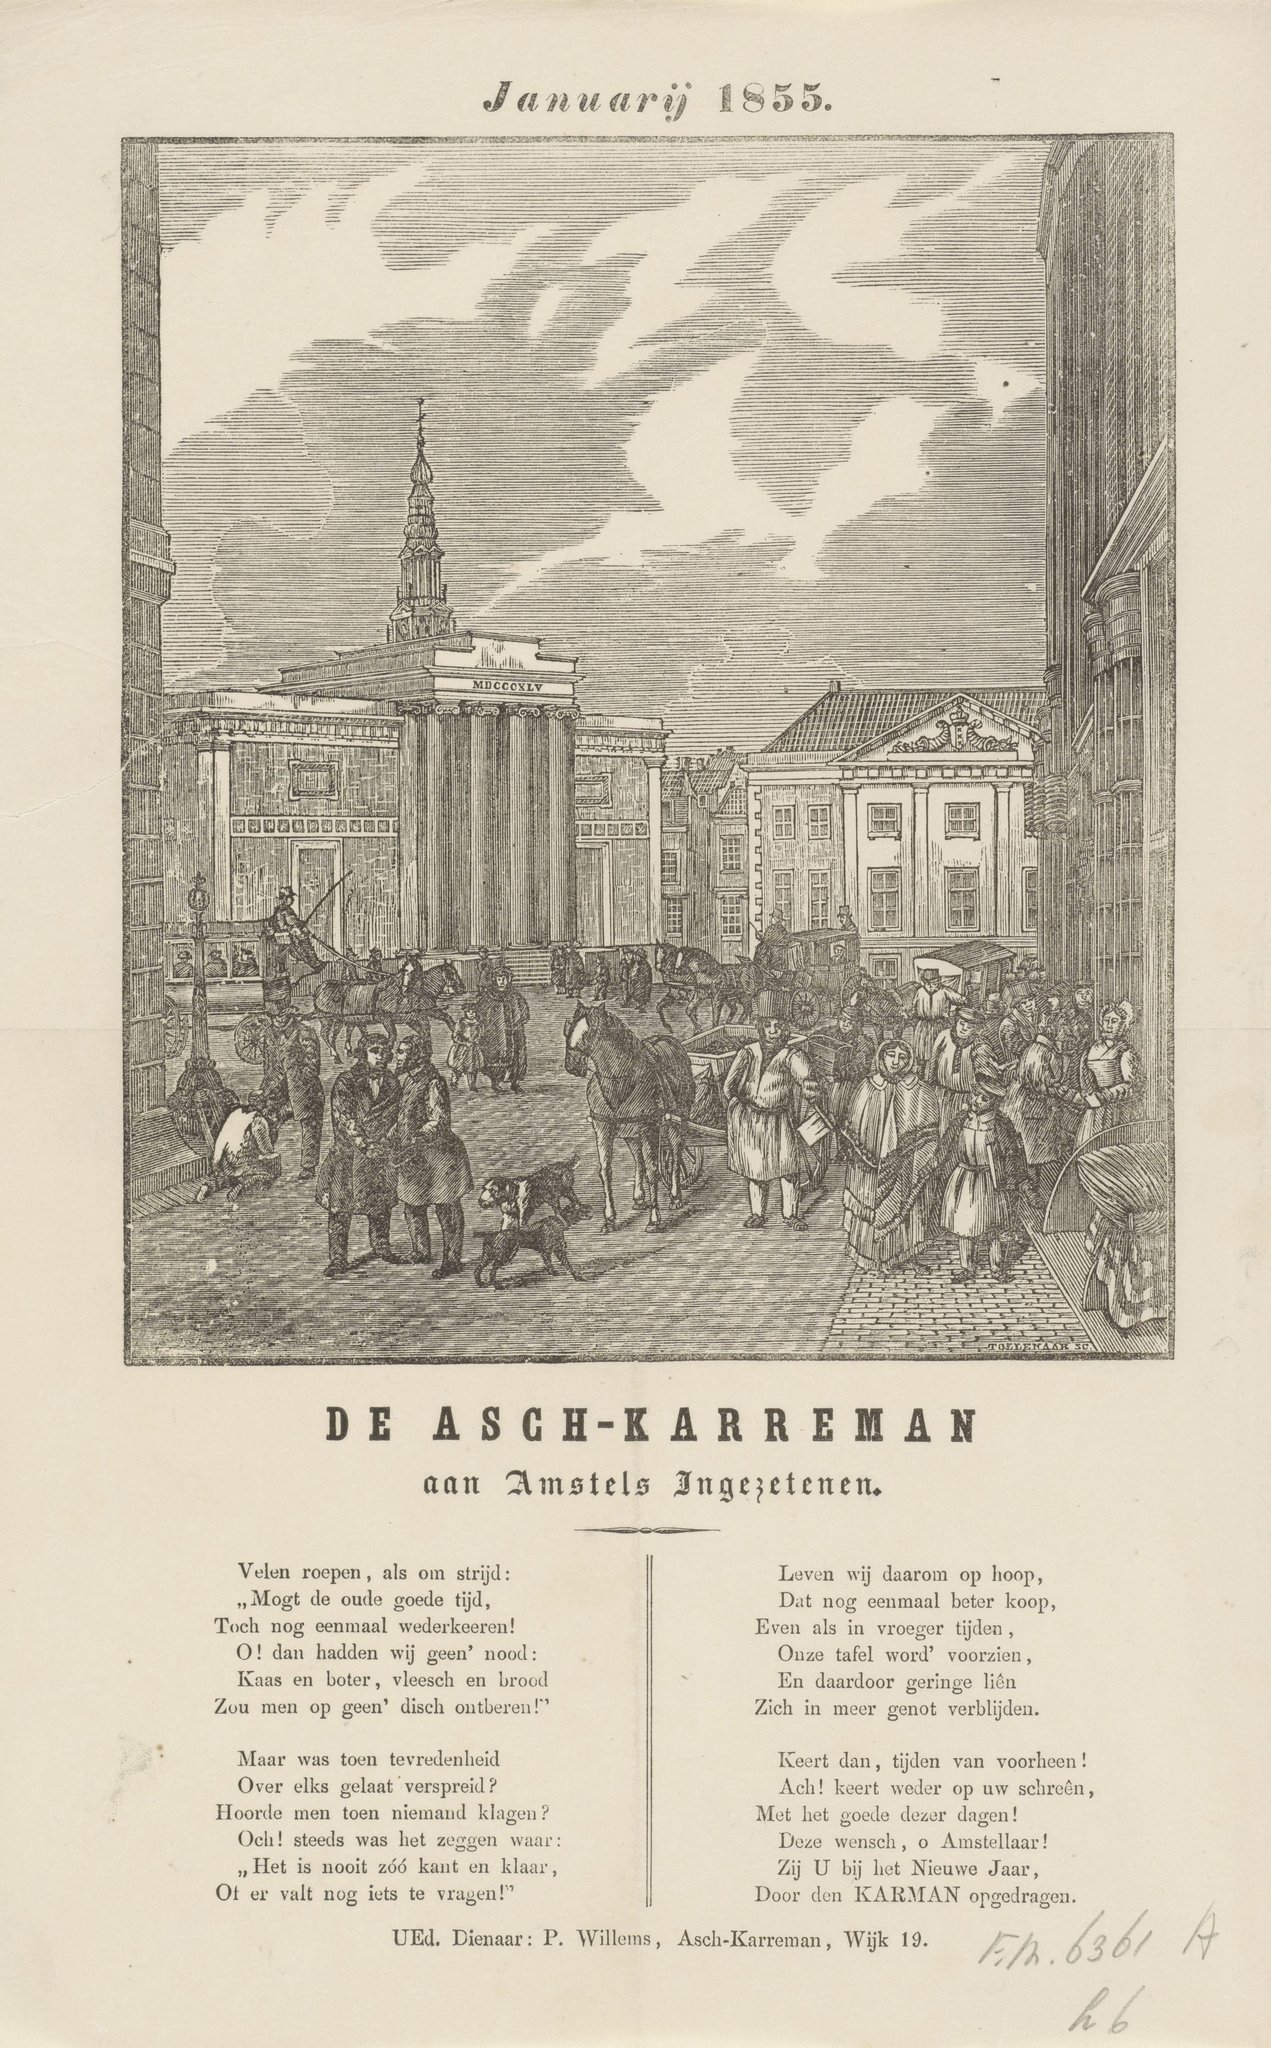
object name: print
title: Nieuwjaarswens van de Amsterdamse askarrenmannen voor het jaar 1855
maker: dirk wijbrand tollenaar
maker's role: print maker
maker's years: 1808-1858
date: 1854-1855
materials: paper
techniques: letterpress printing, engraving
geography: netherlands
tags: public road - ii - ideal city, garbage collection, amsterdam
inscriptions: collector's mark: Lugt 2228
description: Nieuwjaarswens namens de askarrenmannen (karrenman of vuilnisman) te Amsterdam voor het jaar 1855. Gezicht op de Dam te Amsterdam met de Beurs van Zocher en het Commandantshuis. Tussen het publiek de vuilnismannen met hun kar. Onderaan een gedicht in twee kolommen. Namens P. Willemse, de askarreman van wijk no. 19.